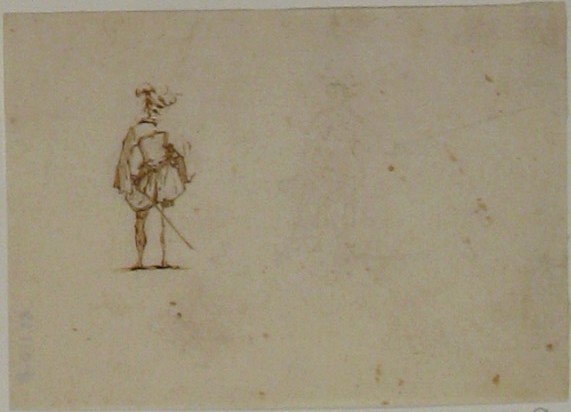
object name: drawing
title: Gentleman seen from the back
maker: jacques callot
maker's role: artist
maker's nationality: french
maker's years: 1592-1635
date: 1601-1633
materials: ink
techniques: pen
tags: men